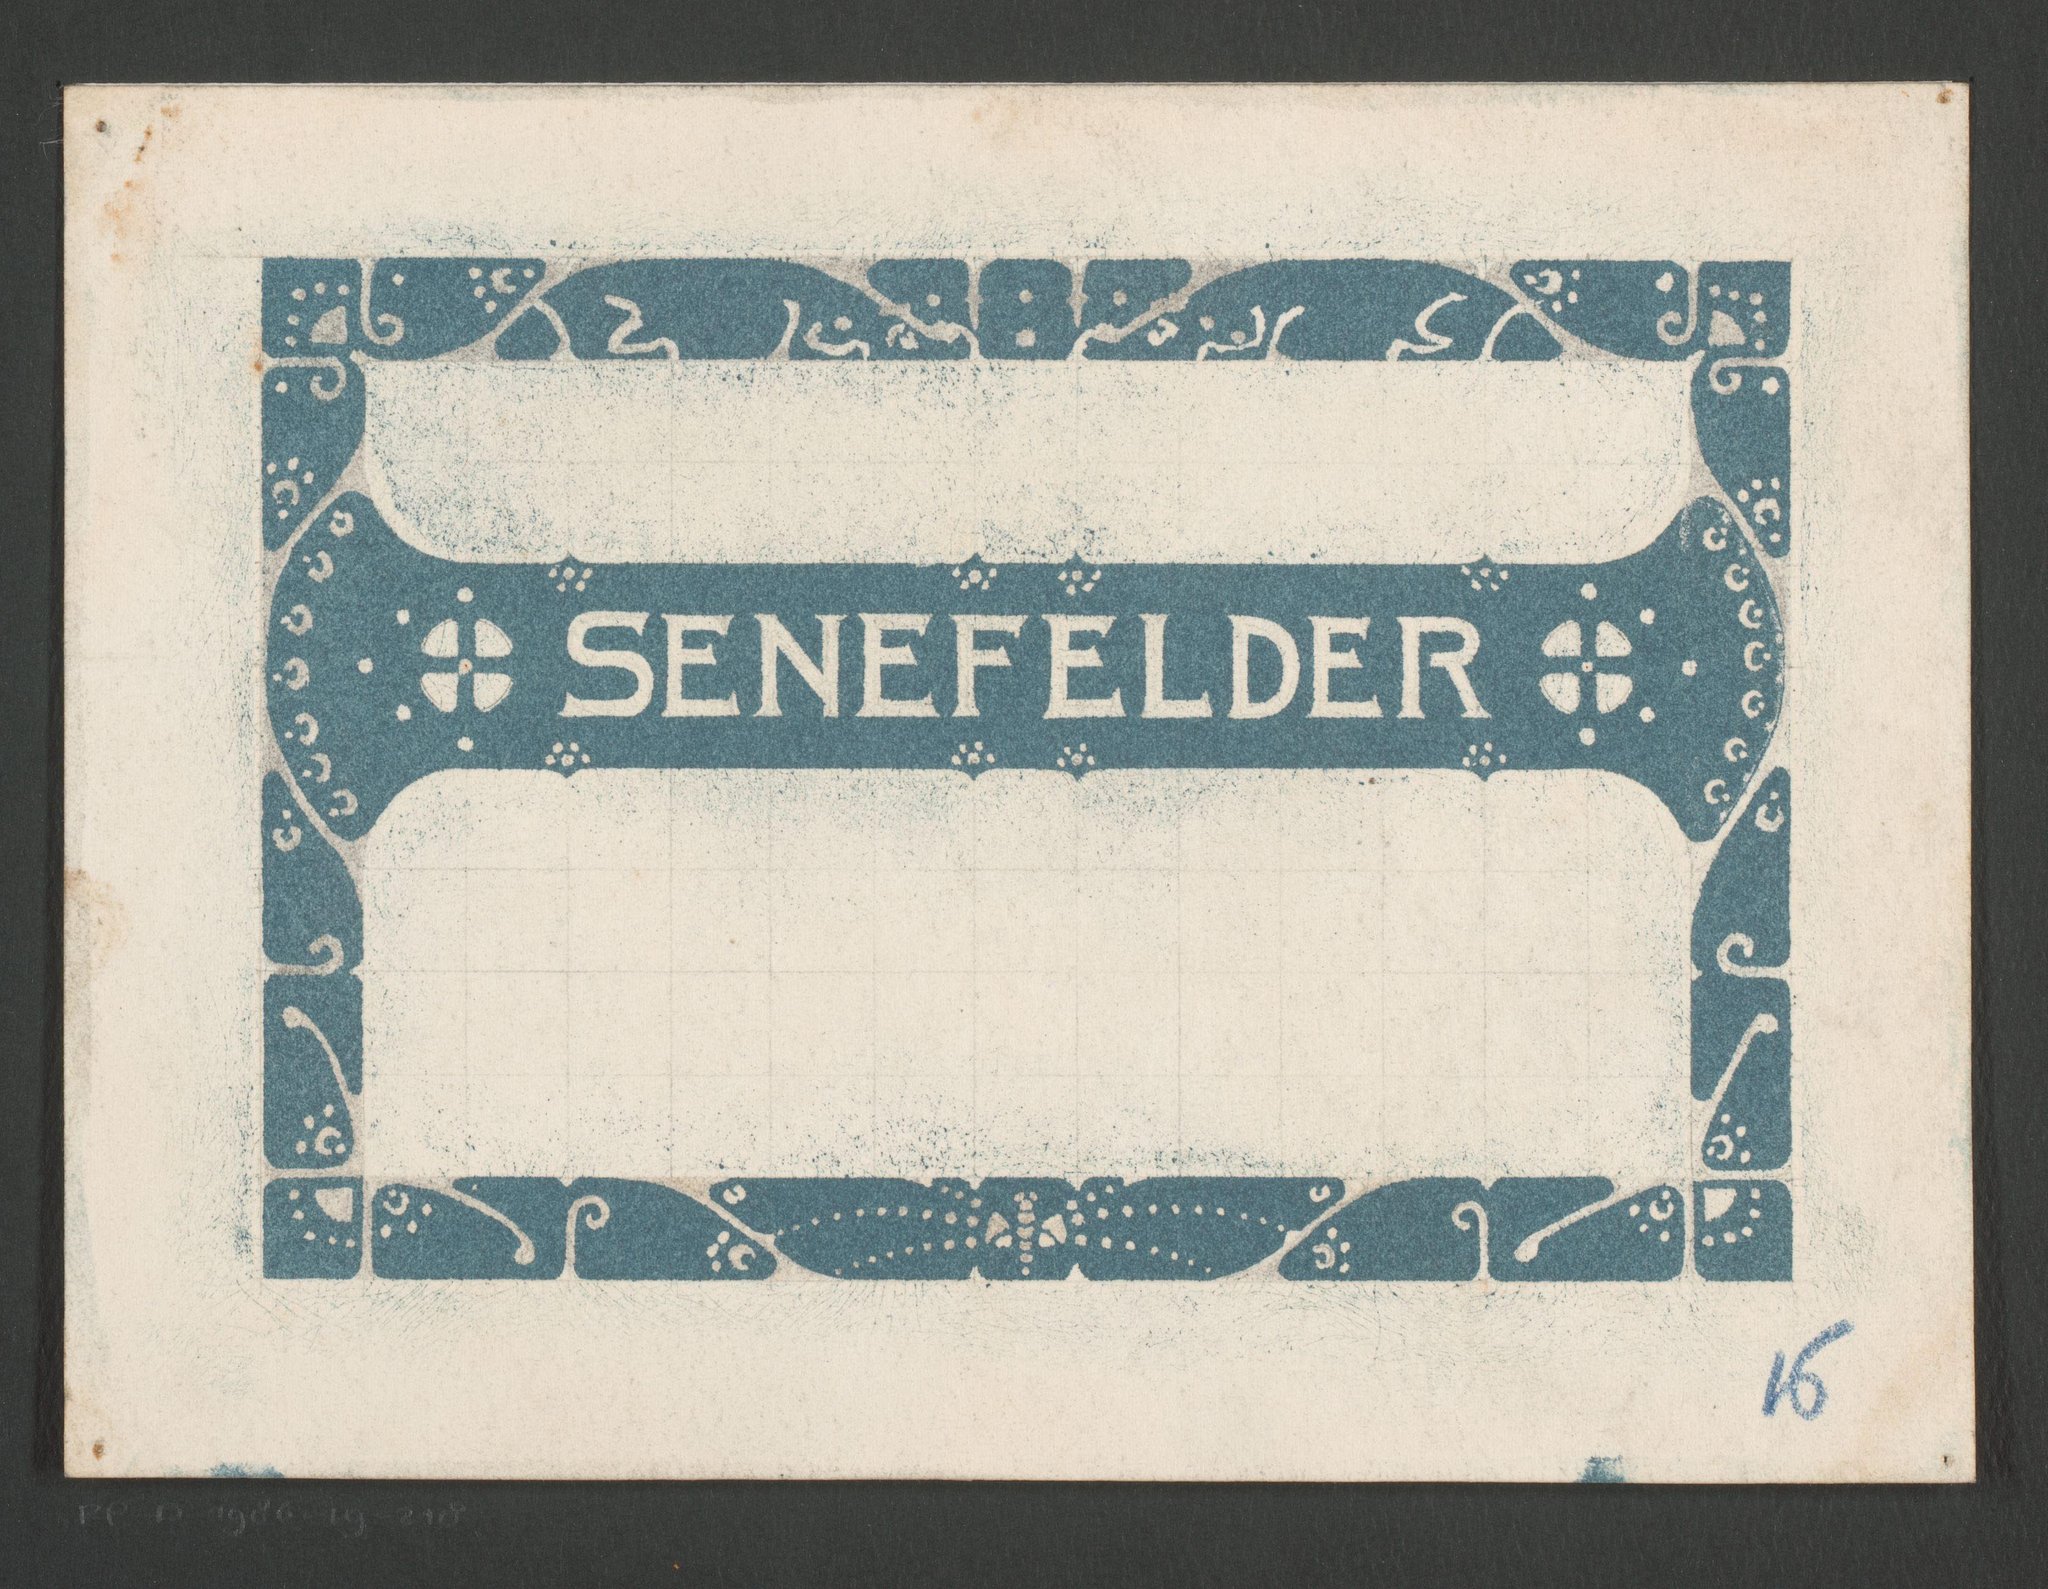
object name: print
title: Ontwerp voor een advertentie van Steendrukkerij Senefelder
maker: reinier willem petrus de vries (1874-1953)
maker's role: draughtsman, print maker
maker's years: 1874-1953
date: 1906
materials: paper, pencil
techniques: lithograph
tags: drukkerij, steendrukker, stoomsteendrukkerij senefelder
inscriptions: number: ‘16’, factory mark, collector's mark: ‘R:MVS.’